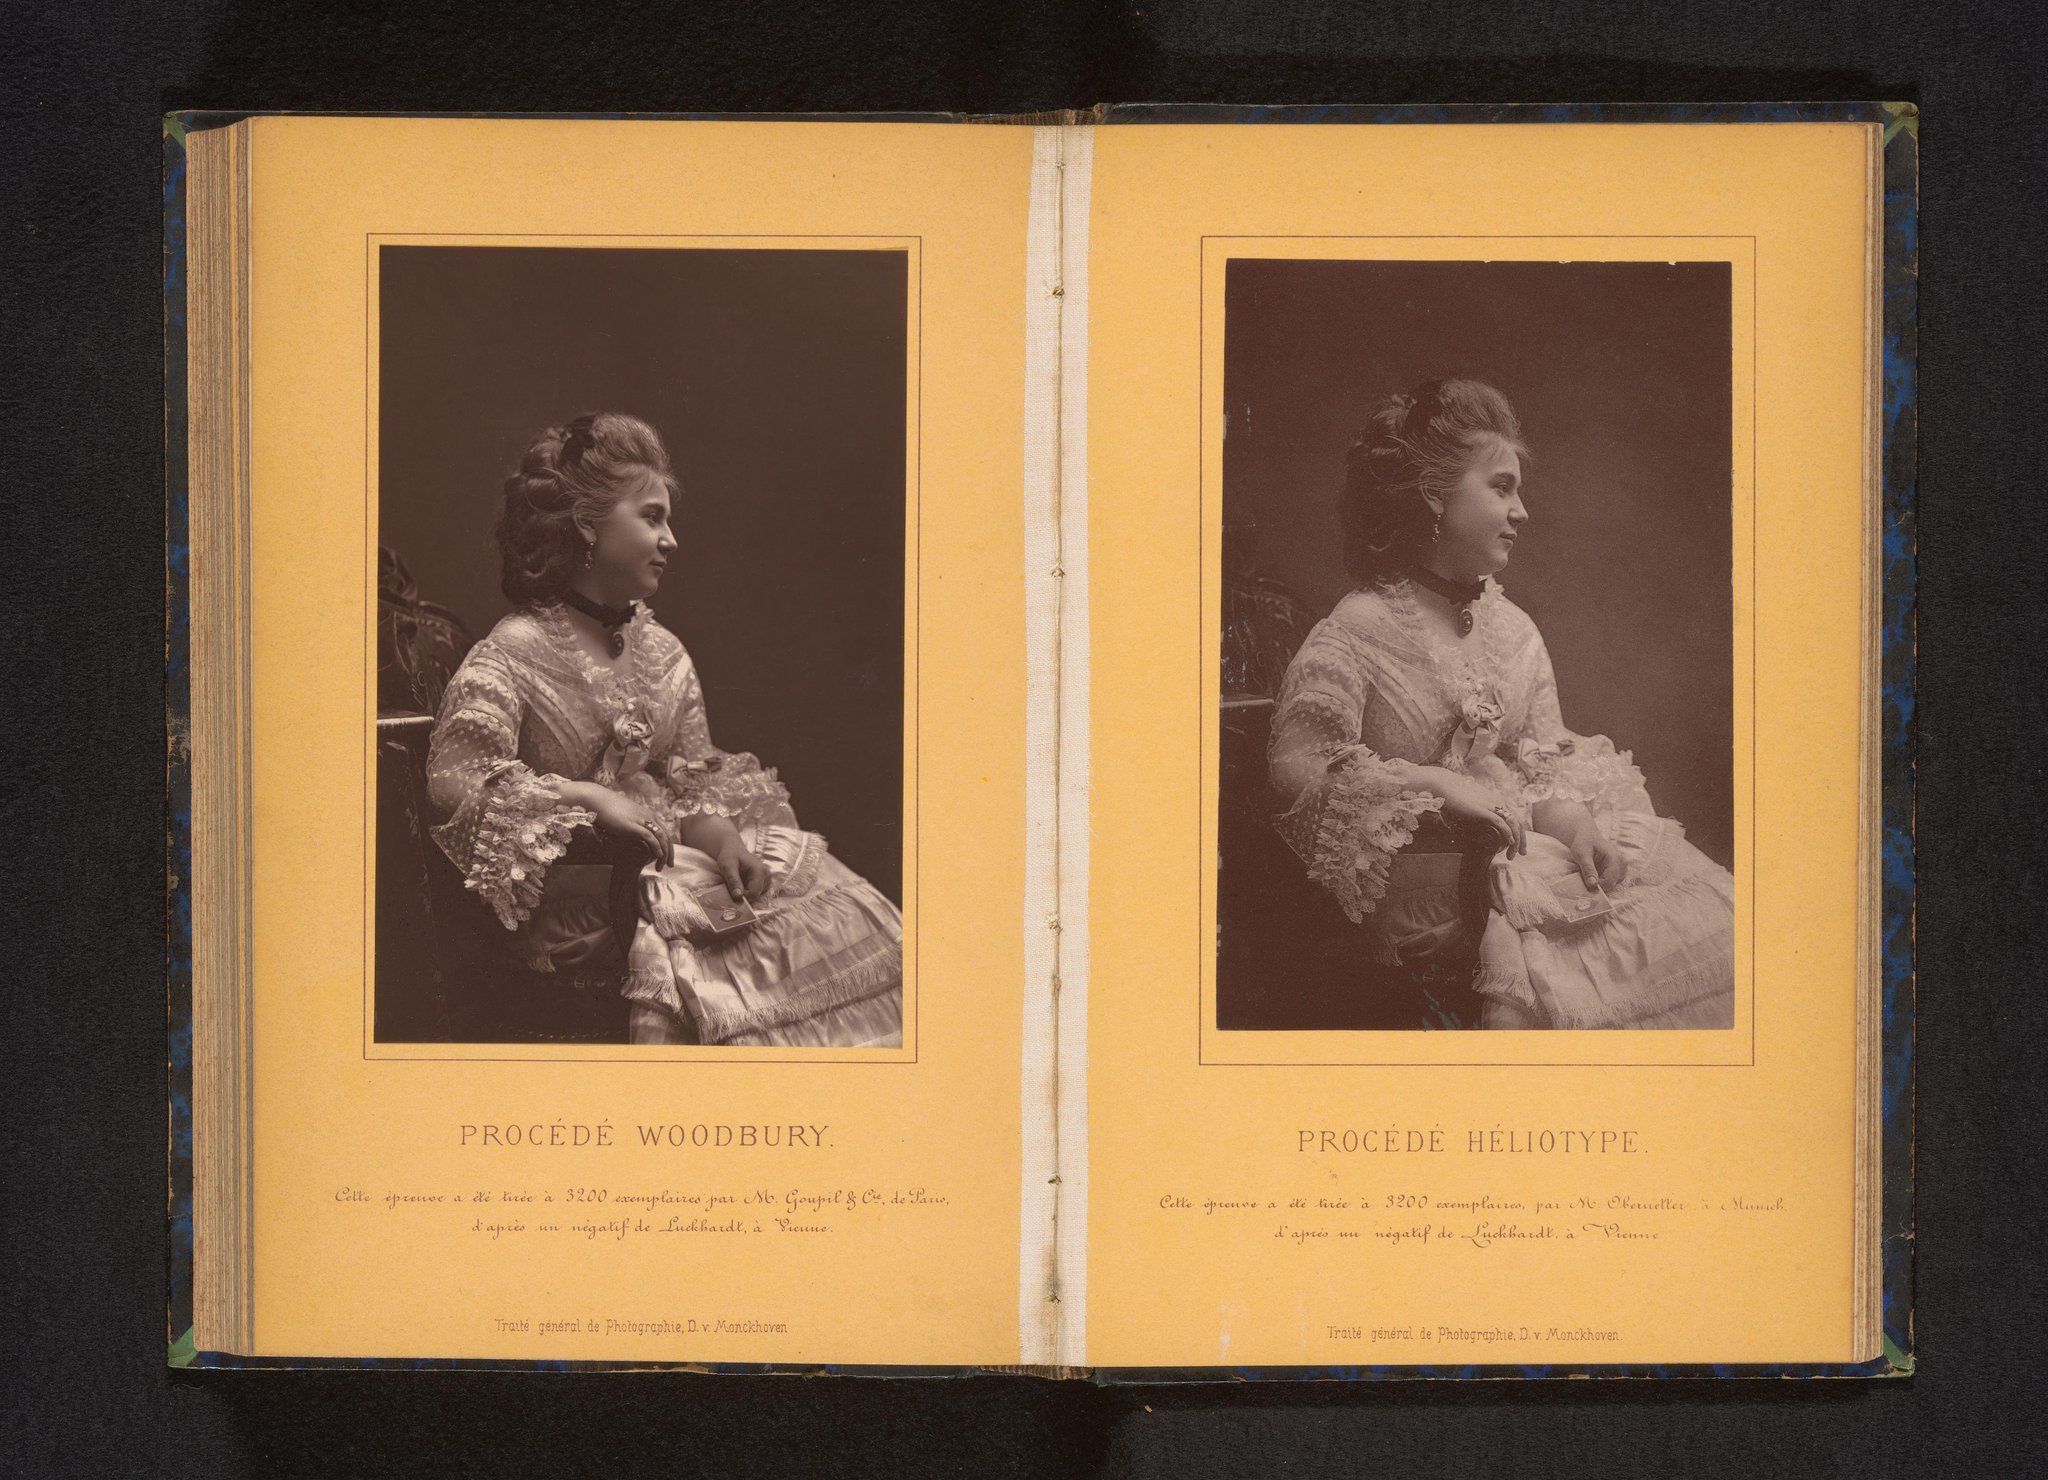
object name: photomechanical print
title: Portret van een onbekende jonge vrouw met in haar hand een foto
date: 1868-1873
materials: paper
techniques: photograph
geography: munich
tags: adult woman, photograph, historical persons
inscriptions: inscription: ‘Cette epreuve a été tirée à 32000 exemplaires par M. Oberneller, à Munich/ (...)’